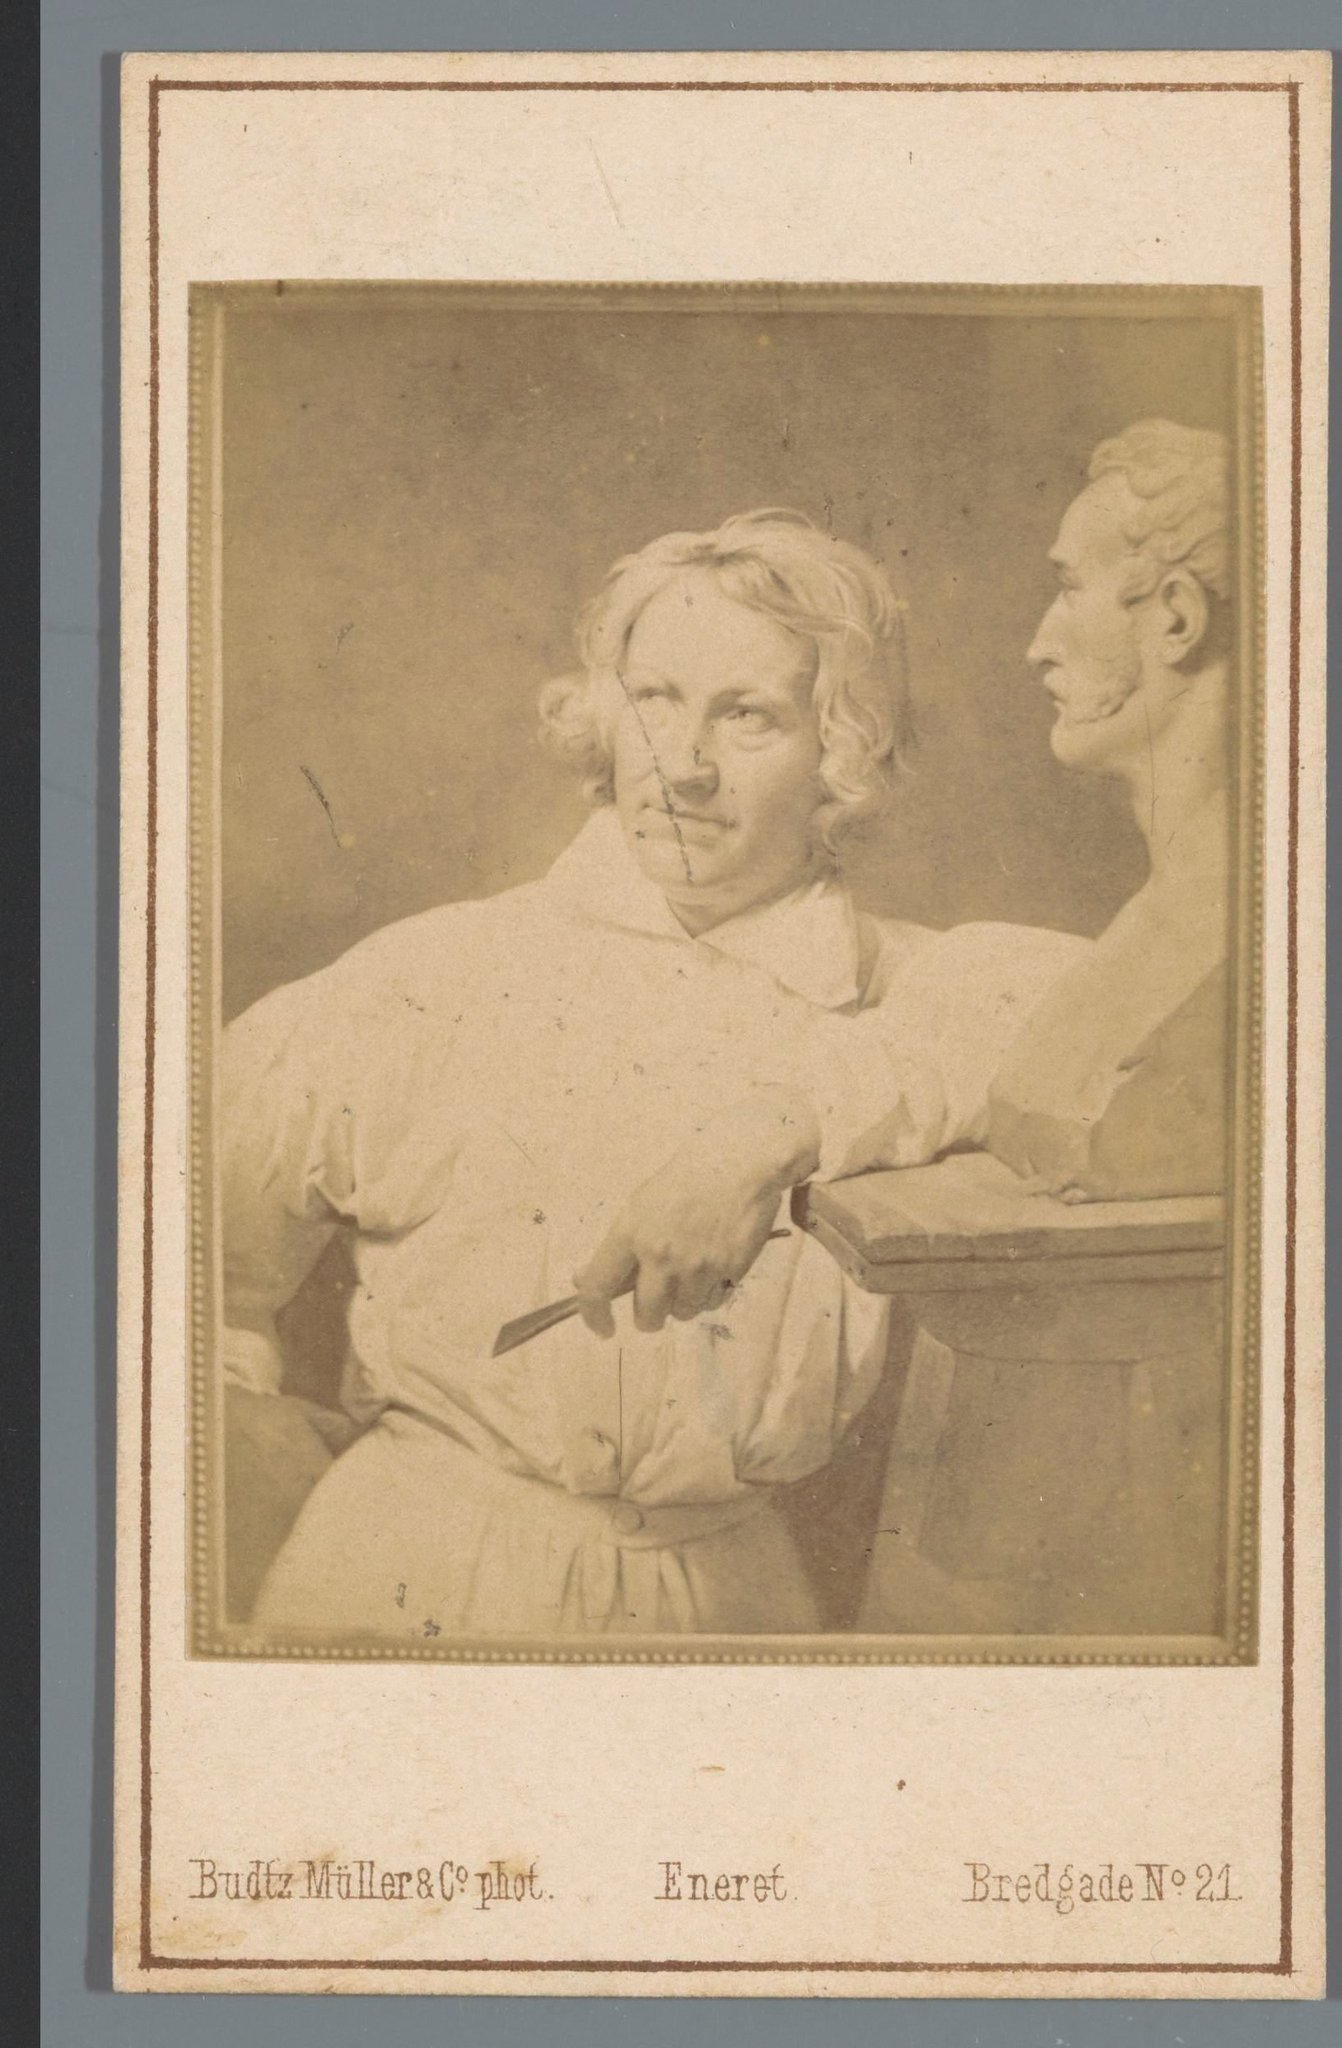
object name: carte de visite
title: Fotoreproductie van een geschilderd portret van Bertel Thorvaldsen, door Horace Vernet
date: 1862-1904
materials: cardboard, paper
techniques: albumen print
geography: copenhagen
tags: copenhagen (city), draughtsman, sculptor, bertel thorvaldsen, portrait, self-portrait of sculptor, historical persons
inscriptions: inscription: ‘Eneret.’, inscription: ‘Khl. Dansk, Svensk og Norsk Hof-Fotograf/ Fotogr. Atelier/ ved/ Budtz Müller & Co./ Bredgade 21 Norgesgade/ Kiöbenhavn.’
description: Het portret bevindt zich nu in de collectie van The Metropolitan Museum of Art, New York.